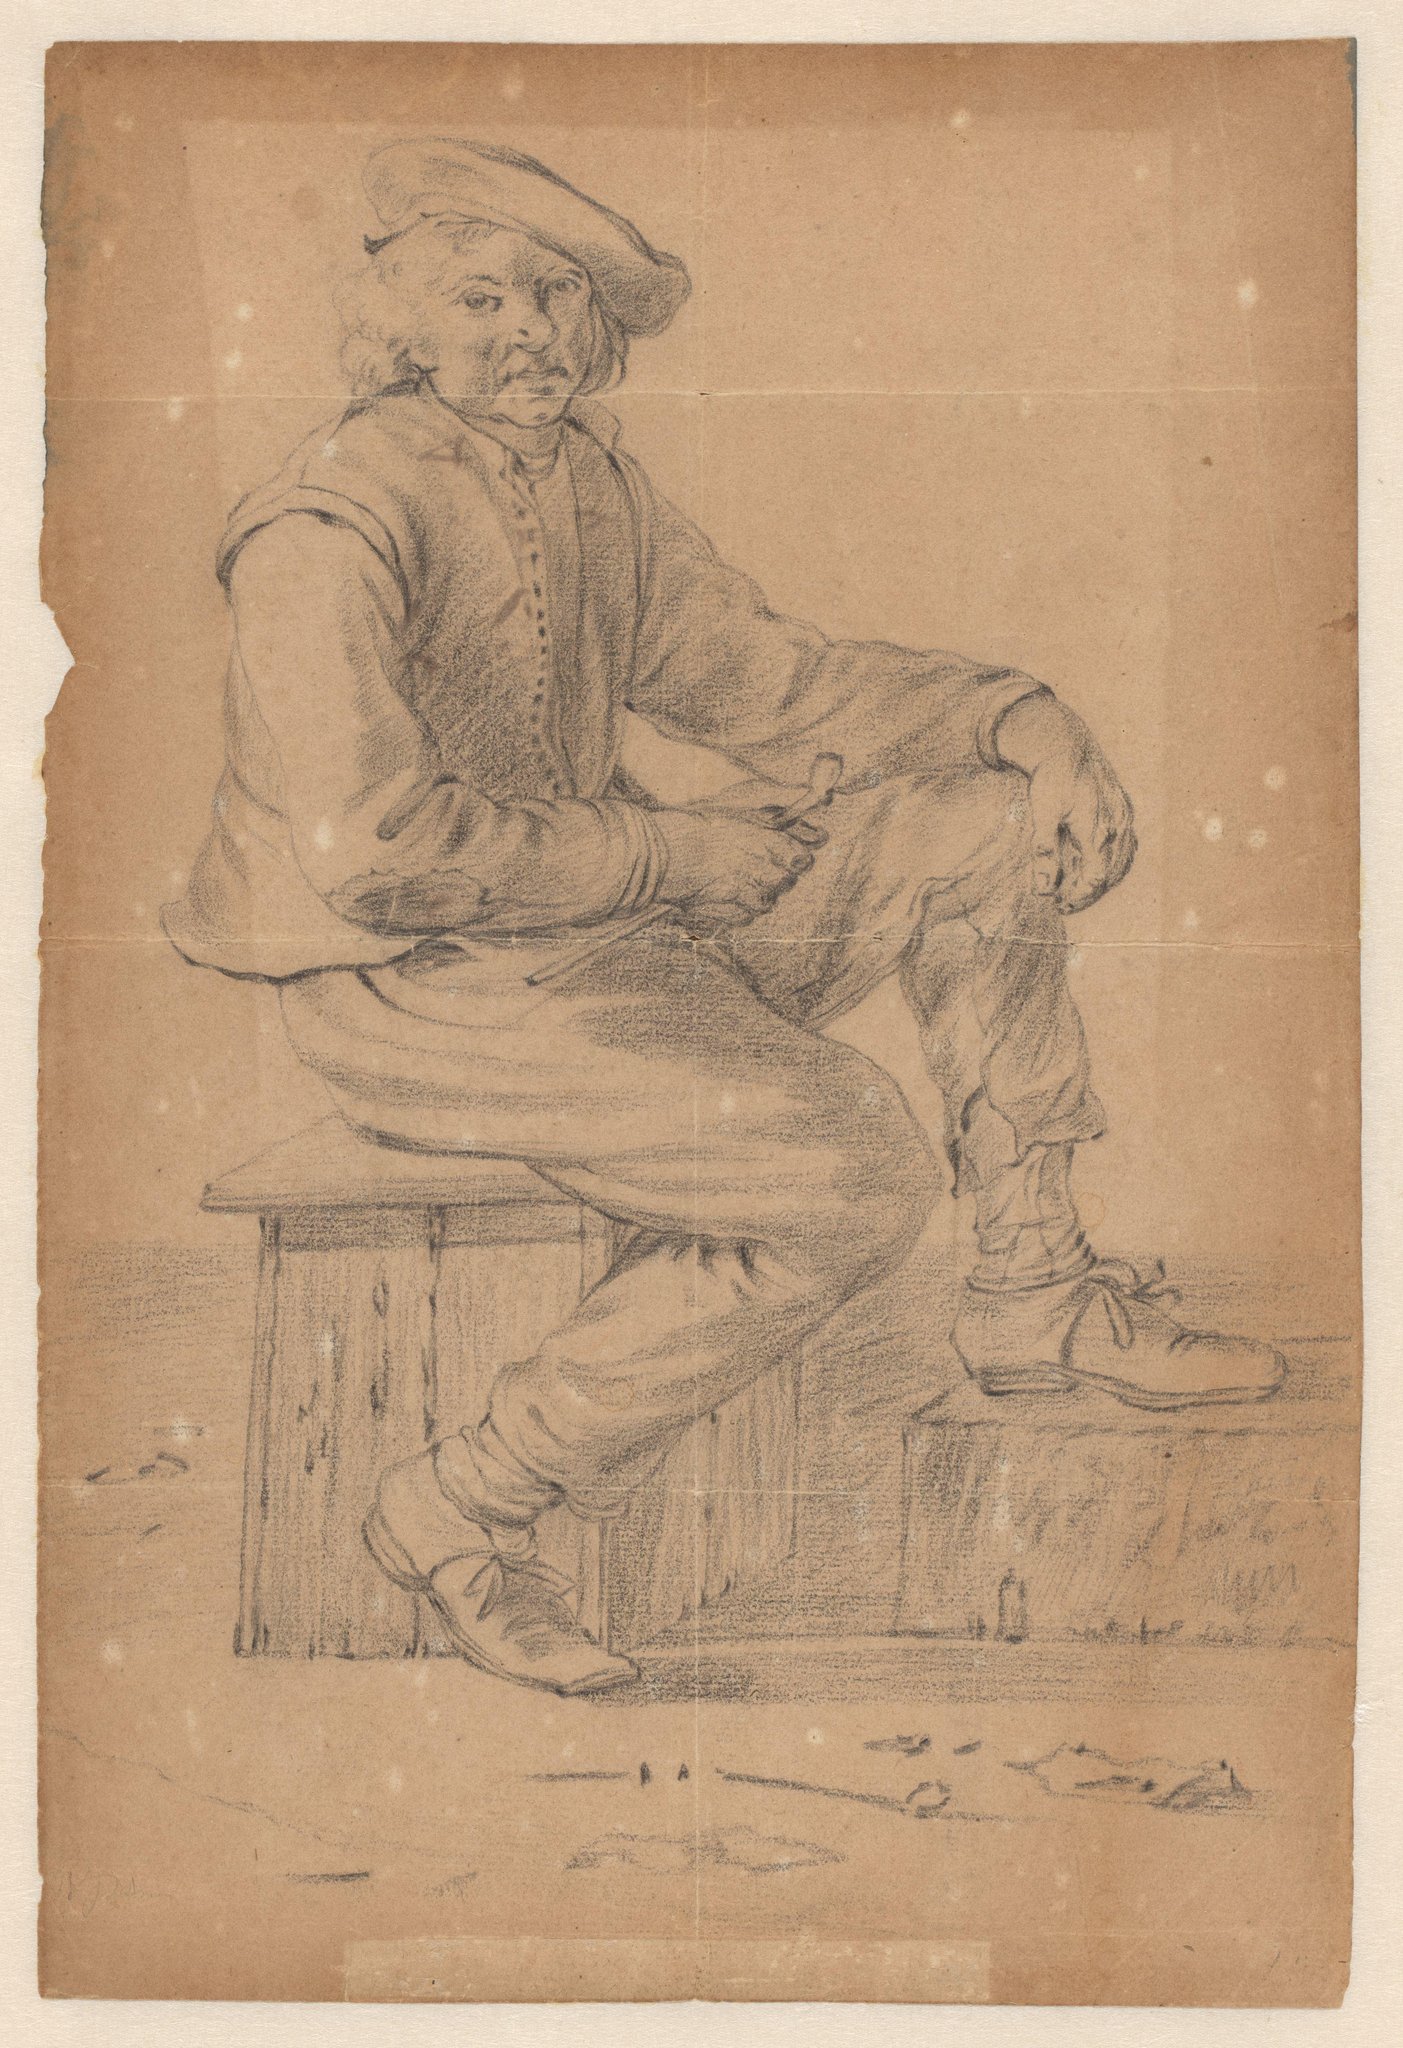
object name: drawing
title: Seated Man with a Pipe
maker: cornelis saftleven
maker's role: draughtsman, painter, print maker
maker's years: 1607-1681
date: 1662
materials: chalk, paper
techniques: drawing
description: Vermoedelijk eigenhandige kopie van RP-T-1989-104. Het adres en stempel op de verso tonen aan dat de kunstenaar dit blad naar zijn broer Herman Saftleven in Utrecht stuurde. Beide bladen hebben hetzelfde watermerk.